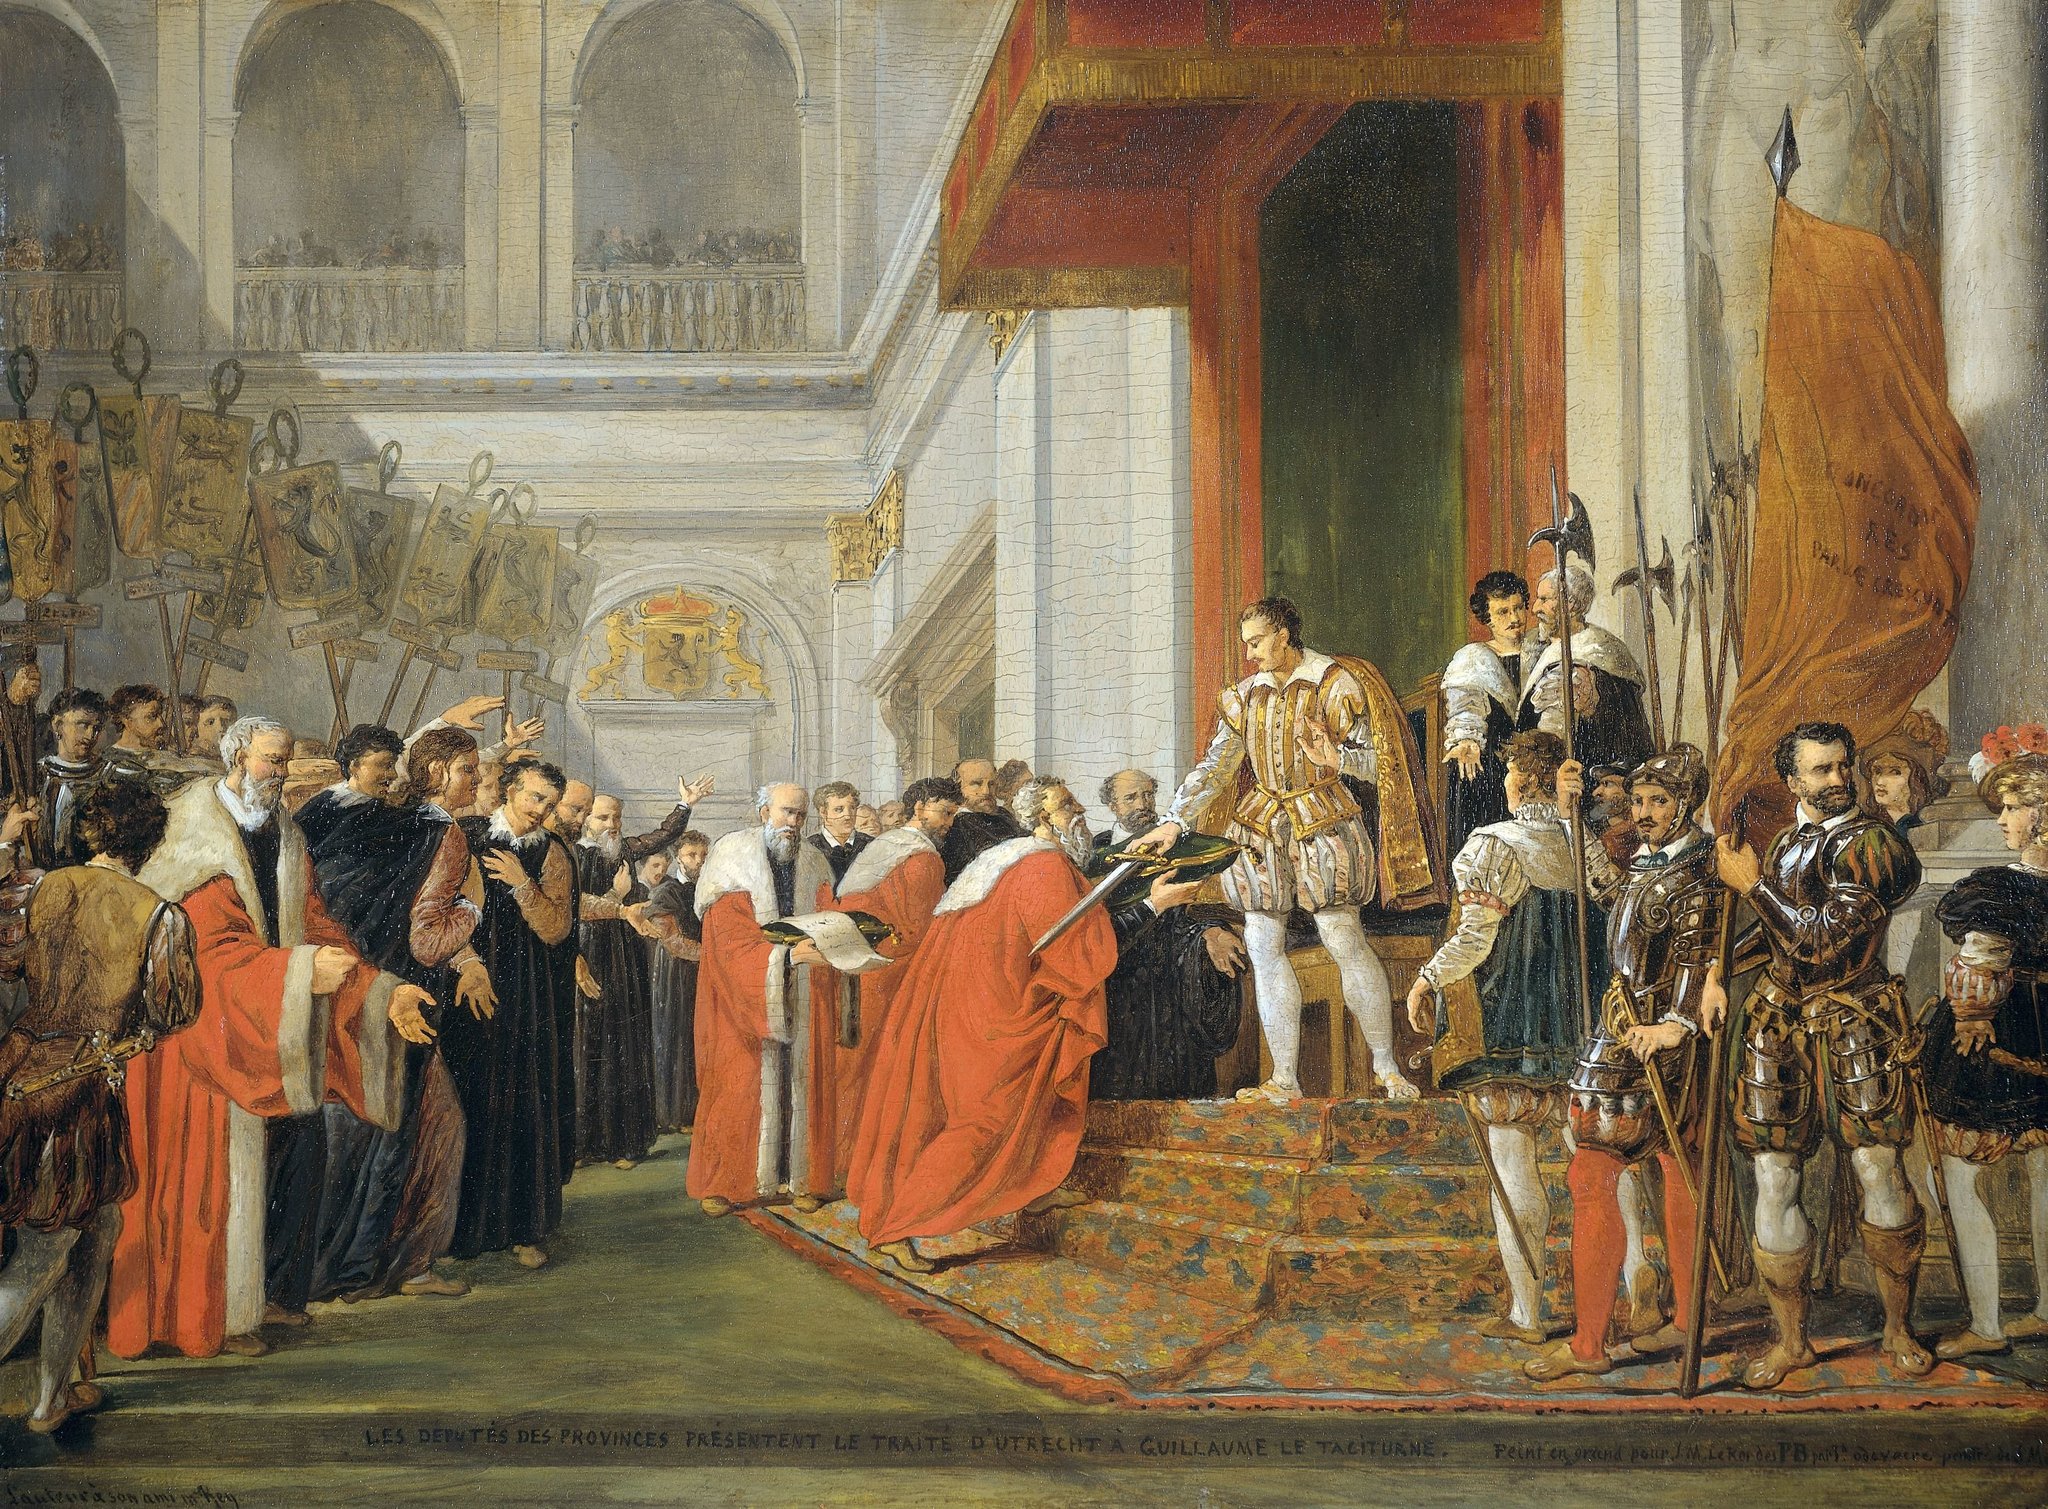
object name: painting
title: The Union of Utrecht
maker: joseph-denis odevaere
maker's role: painter, print maker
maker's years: 1778-1830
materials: oil, panel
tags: delft, william i (prince of orange), provincial government, president ~ head of republic, throne-room, national government, union of utrecht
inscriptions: inscription: ‘L'auteur à son ami Mr. Rey. Les députés des provinces presentent le traité d'Utrecht à Guillaume le Taciturne. Peint en grand pour son S.M. le roi des P.B. par J. Odevaere peintre de S.M.’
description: Presentation of the Charter of the Union of Utrecht to Prince William of Orange, by J.D. Odevaere, 1814/15. This painting is a study for a large canvas which the Bruges artist Odevaere (1776-1830) was commissioned to paint by King William I. It alludes to the historical unity of North and South under the House of Orange. In January 1579 a number of northern provinces signed a treaty of alliance against Spain. Later, this Union was recognised as the cornerstone of the Republic. During the unification of North and South under William I the significance of the Union grew. Since some of the southern provinces had signed the treaty, the Union came to symbolise the ties between North and South. However, the role attributed by the artist to Prince William of Orange is incorrect. The document was never presented to the Prince. He had strong reservations about the text and only acquiesced to the treaty months after it had been signed.